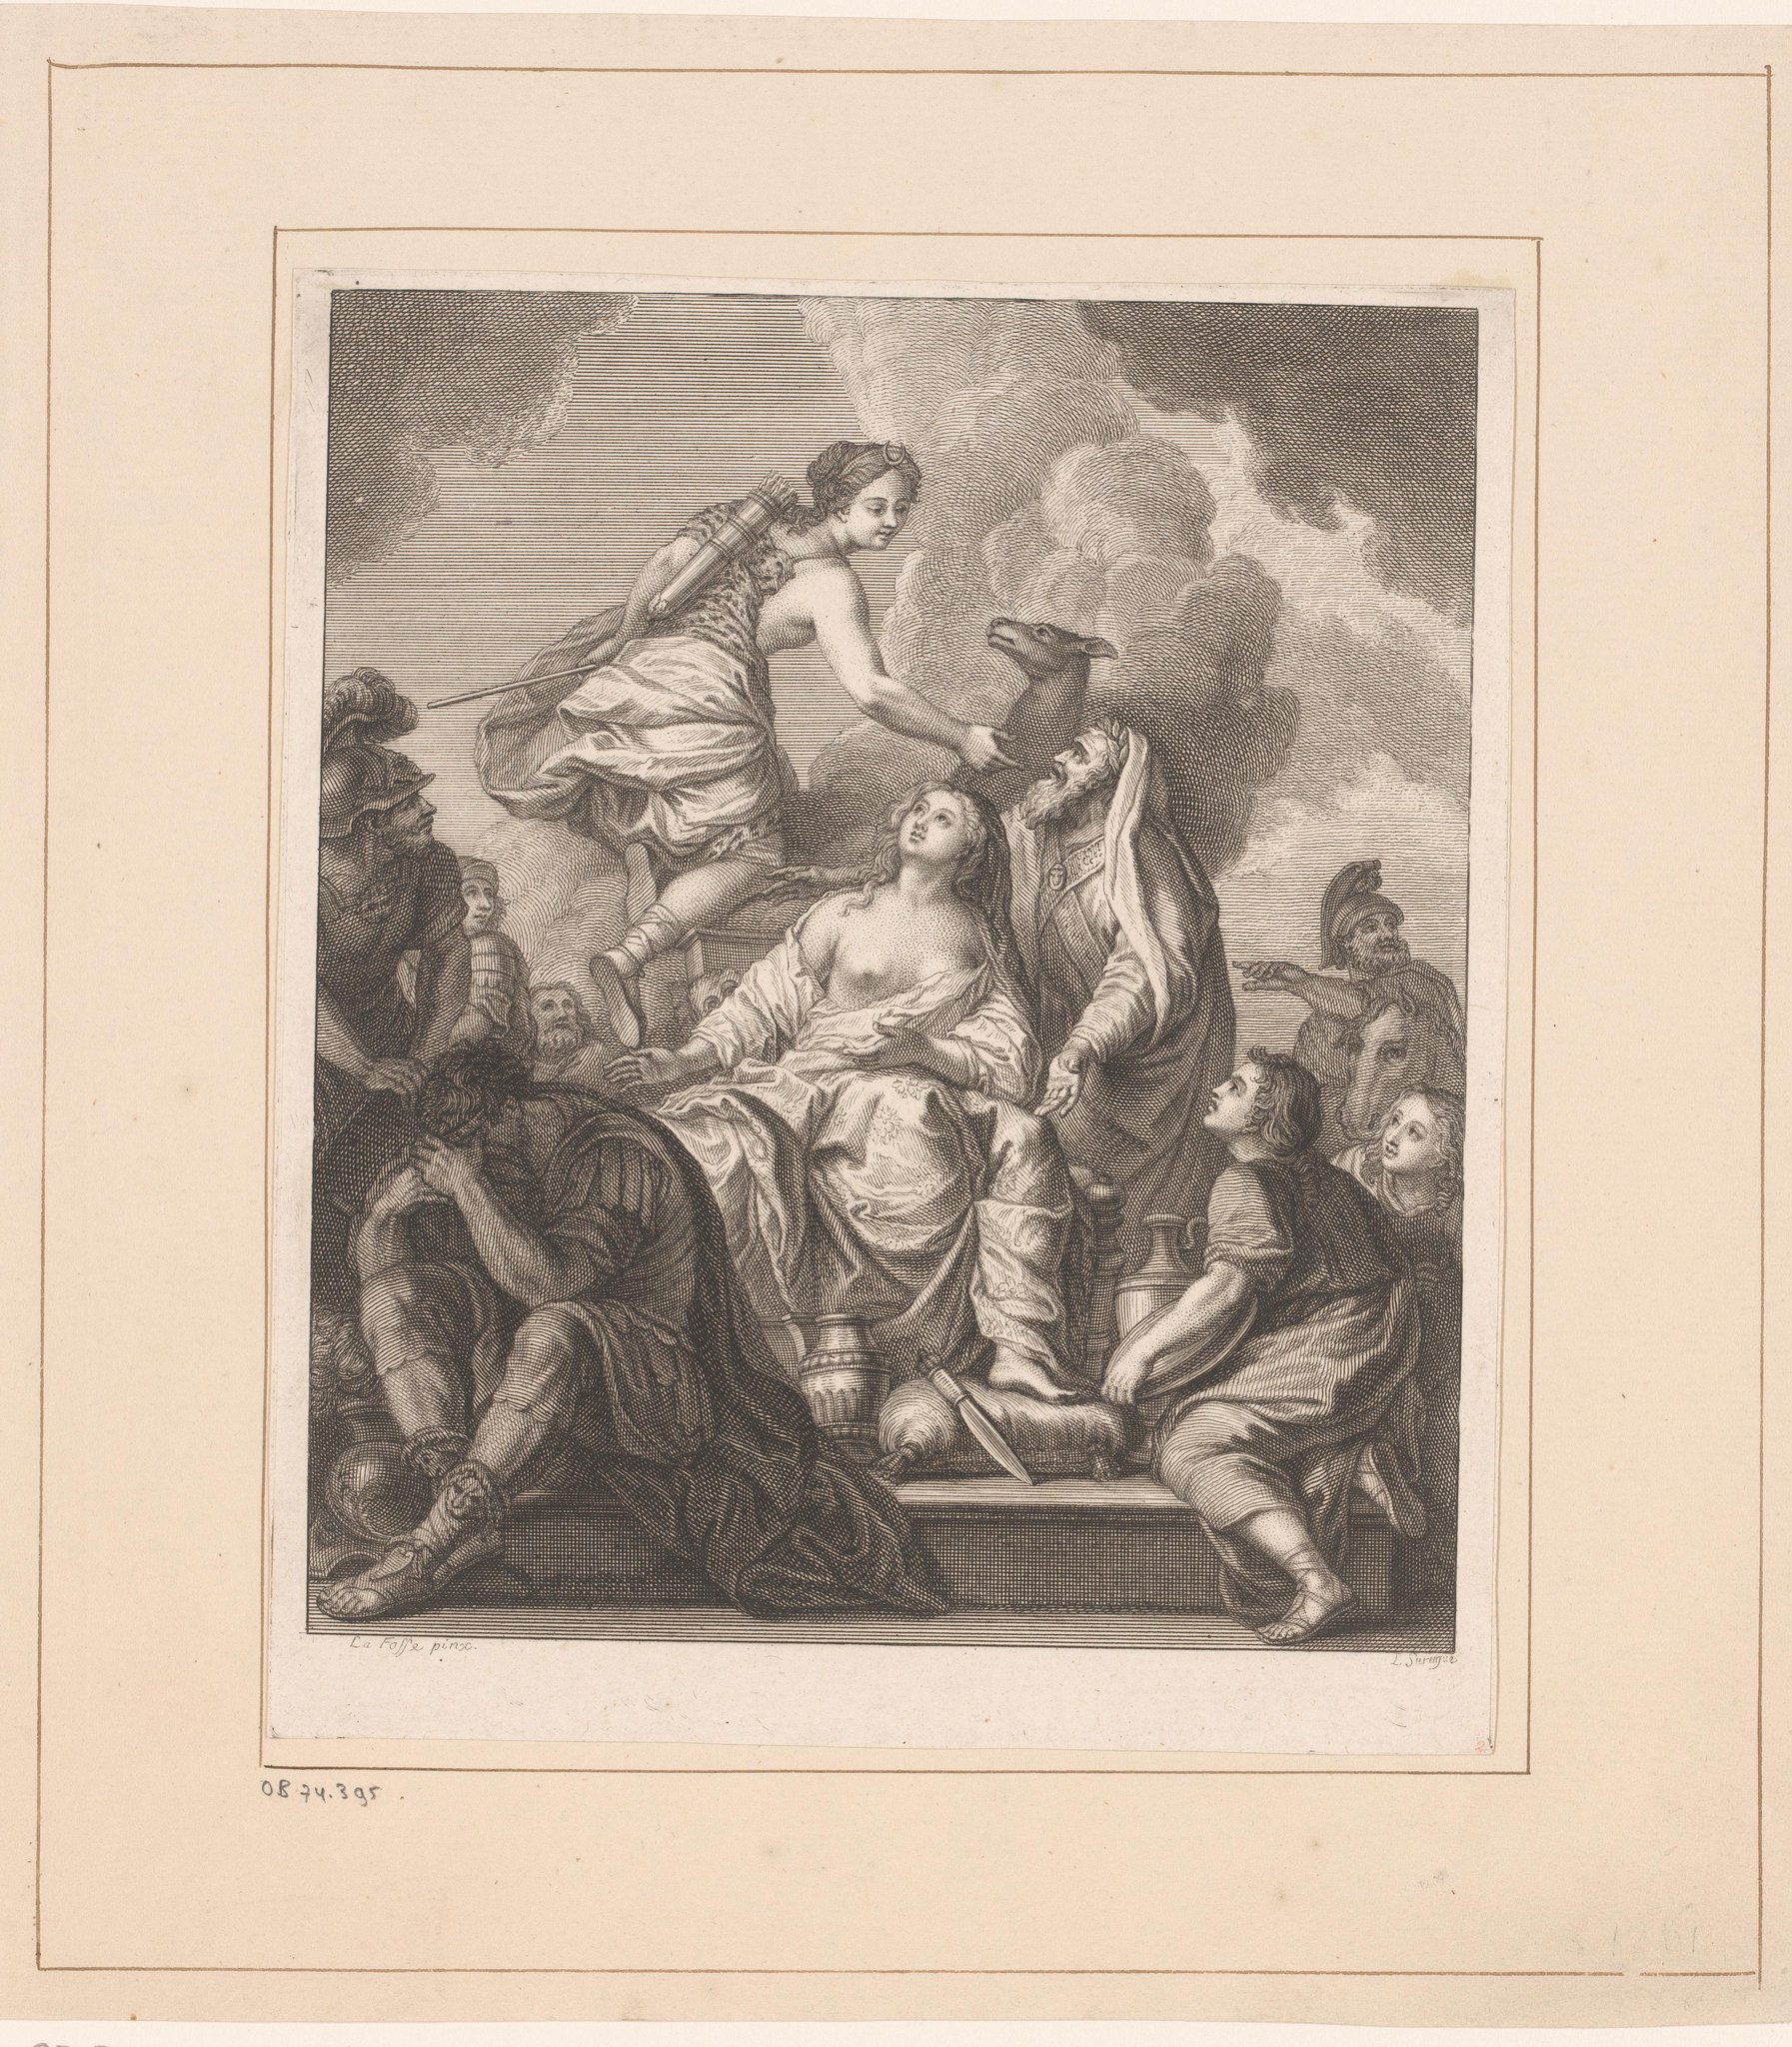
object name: print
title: Offer van Iphigenia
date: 1691-1767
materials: paper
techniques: engraving, etching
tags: hoofed animals: deer, iphigenia is saved by diana, who puts a stag (hind) in her place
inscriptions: collector's mark: Lugt 240